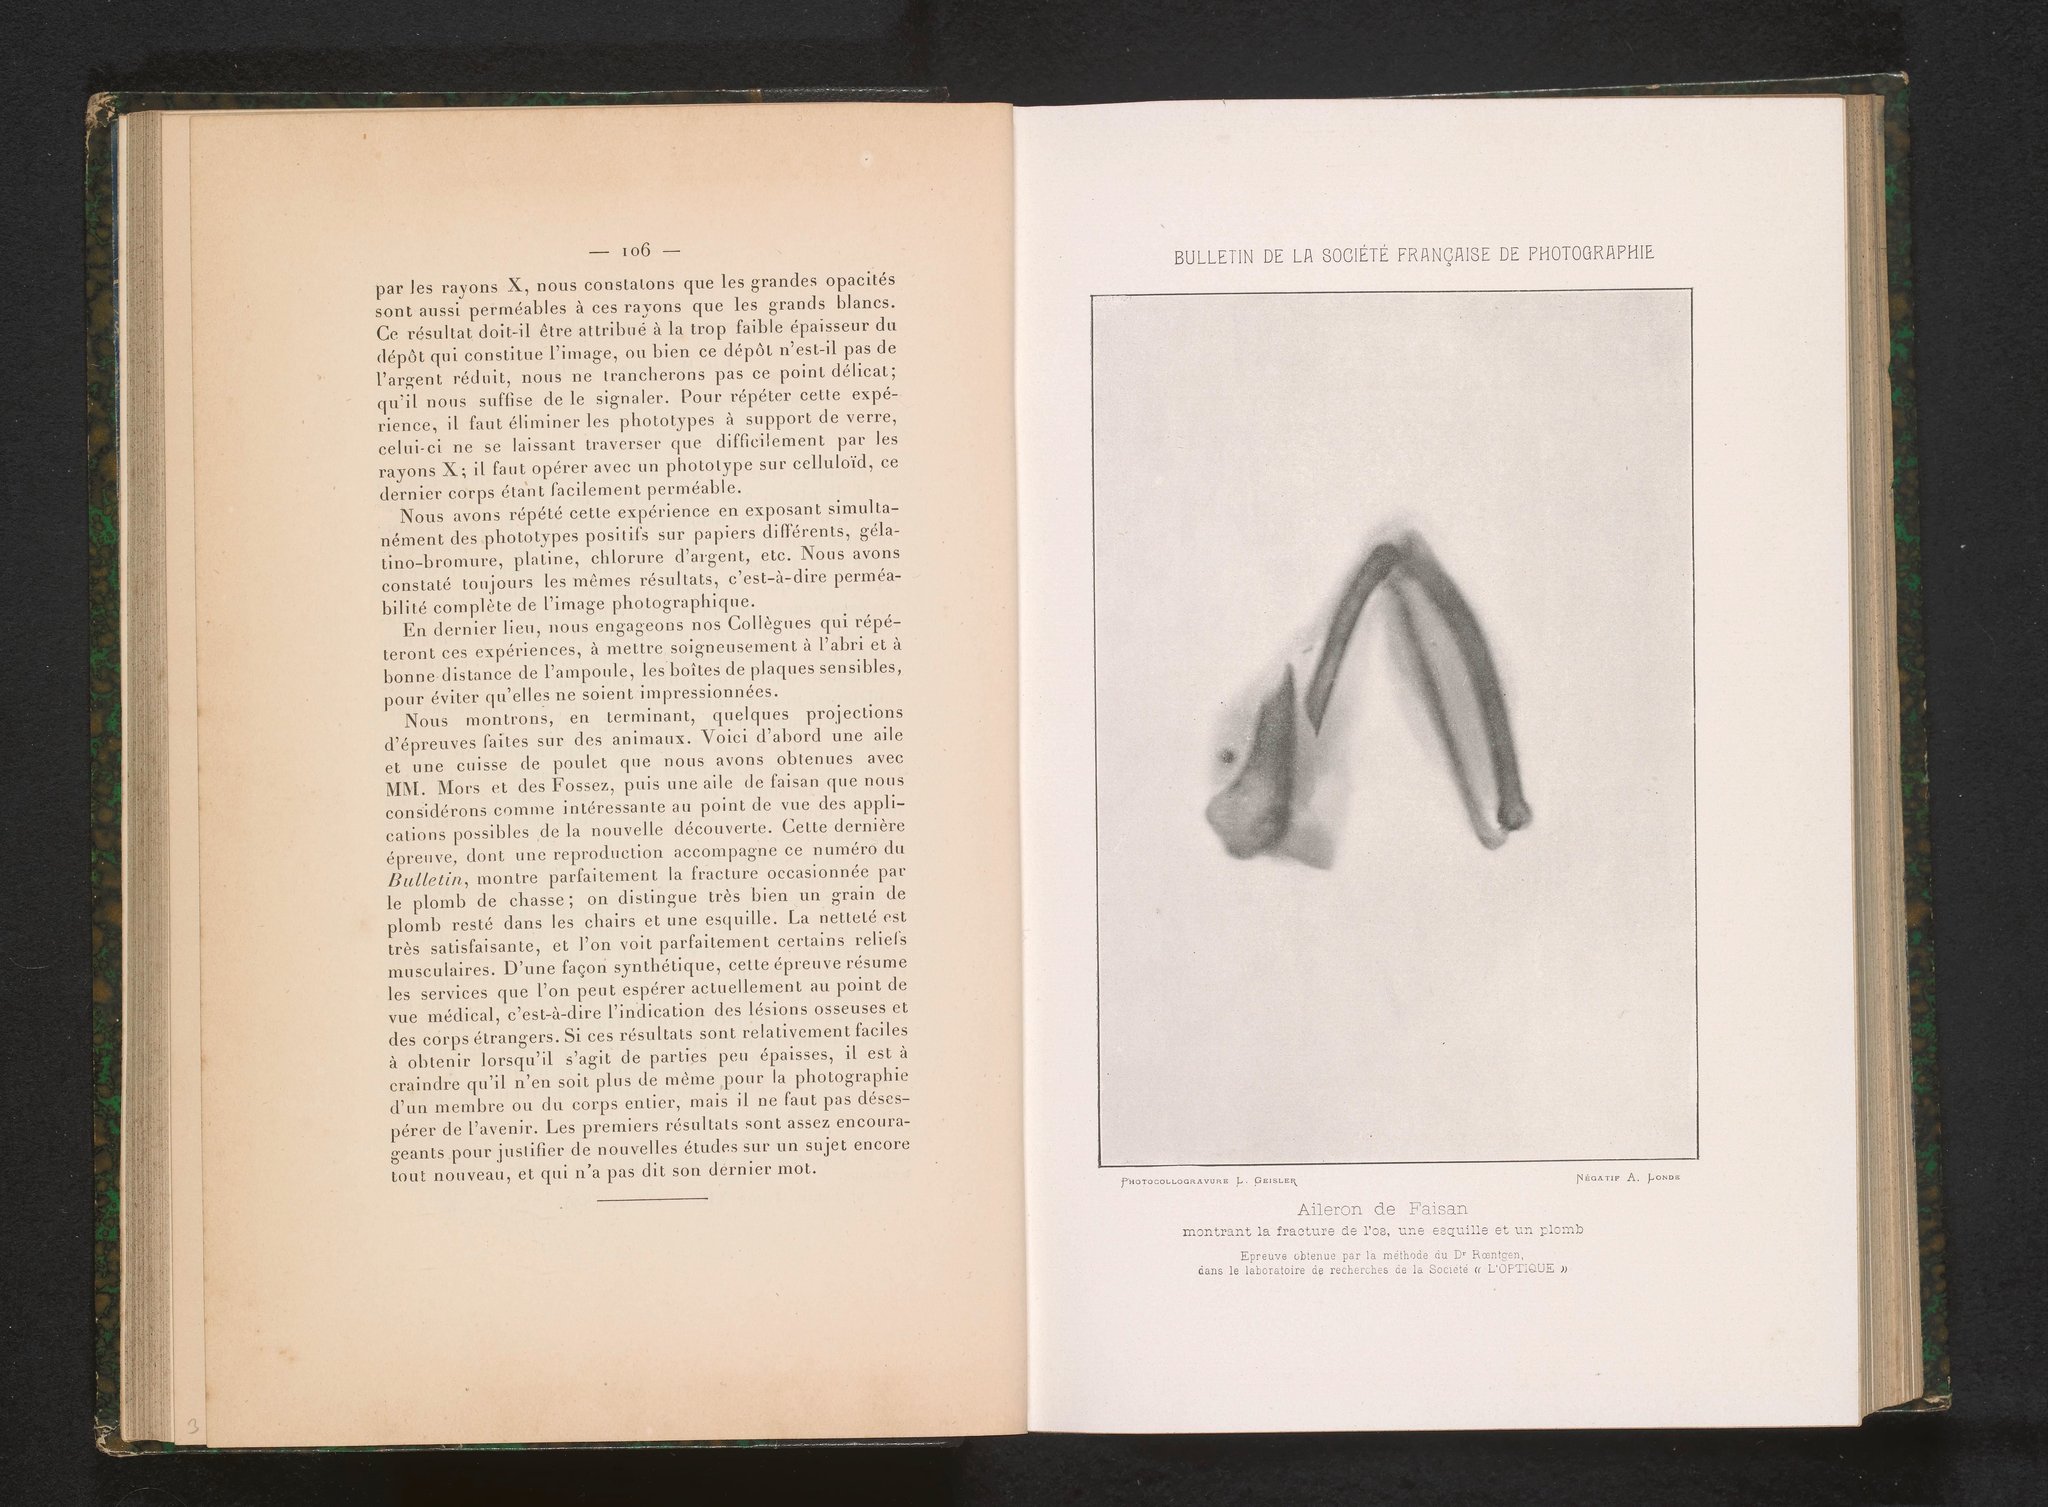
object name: photomechanical print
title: Röntgenfoto van een bot van een fazant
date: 1886-1896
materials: paper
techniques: autotype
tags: bones in general (human body), walker and runner birds: pheasant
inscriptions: inscription: ‘Epreuve obtenue (...) < L'OPTIQUE. >’